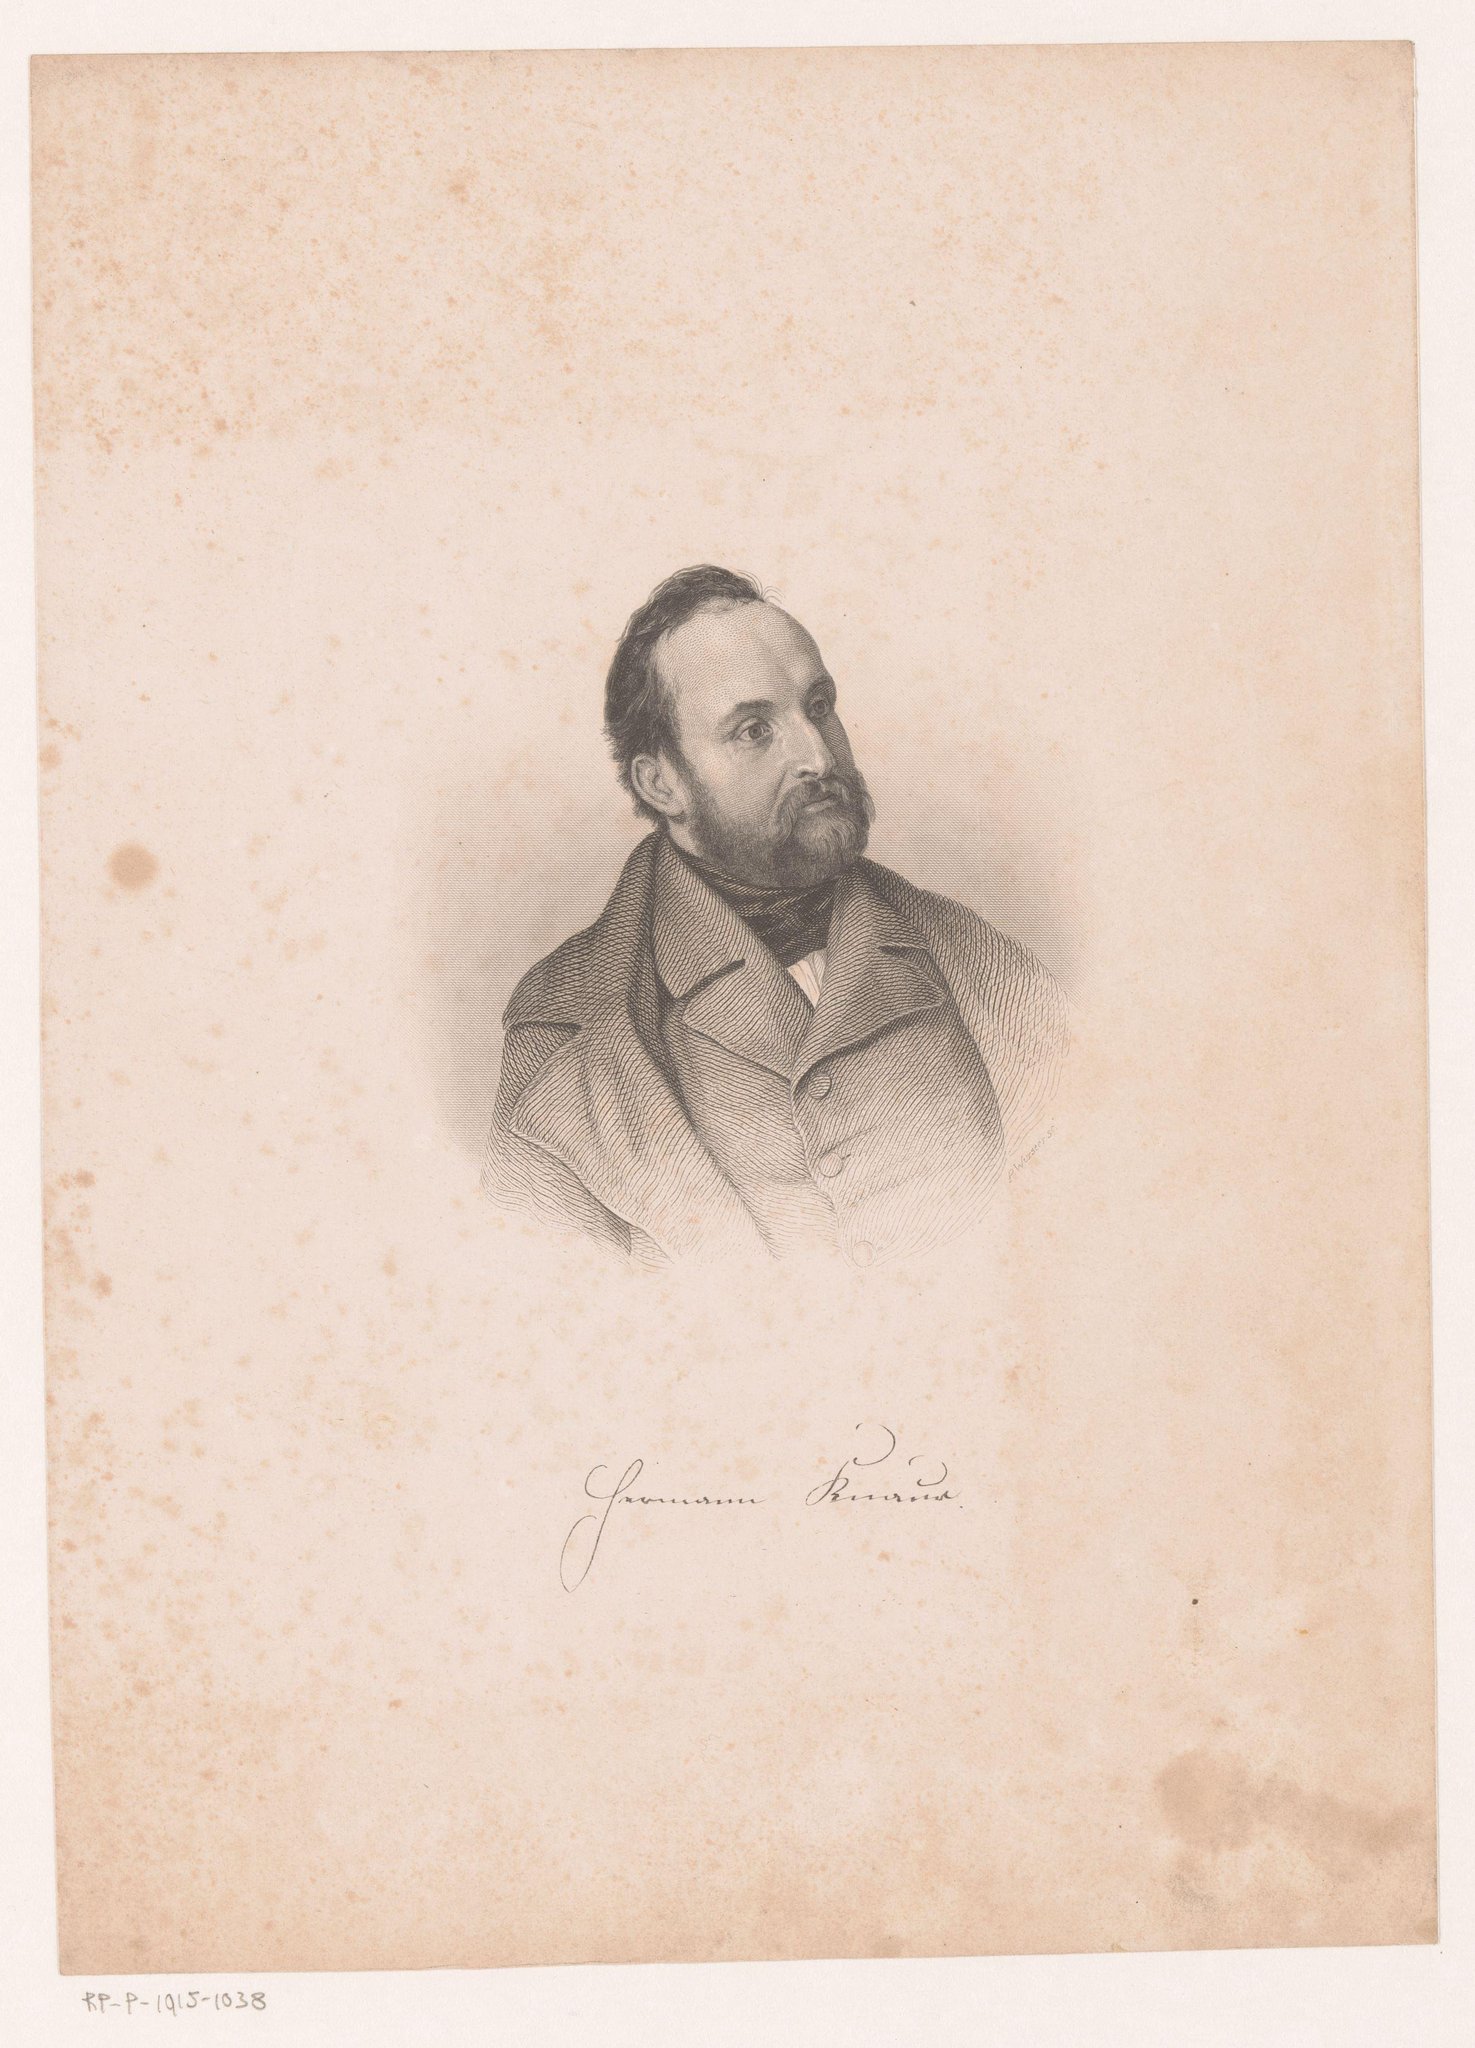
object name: print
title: Portret van Hermann Knaur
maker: p. wurster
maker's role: print maker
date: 1831-1850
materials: paper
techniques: engraving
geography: germany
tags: historical persons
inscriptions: collector's mark: Lugt 2228